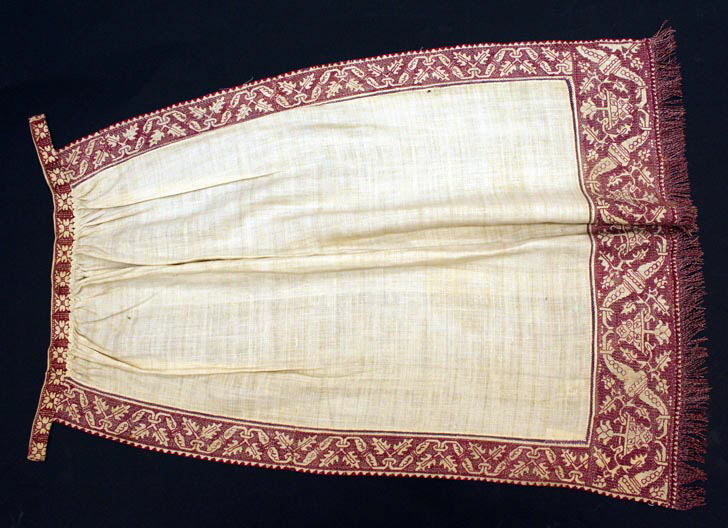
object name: apron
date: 1501-1700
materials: linen